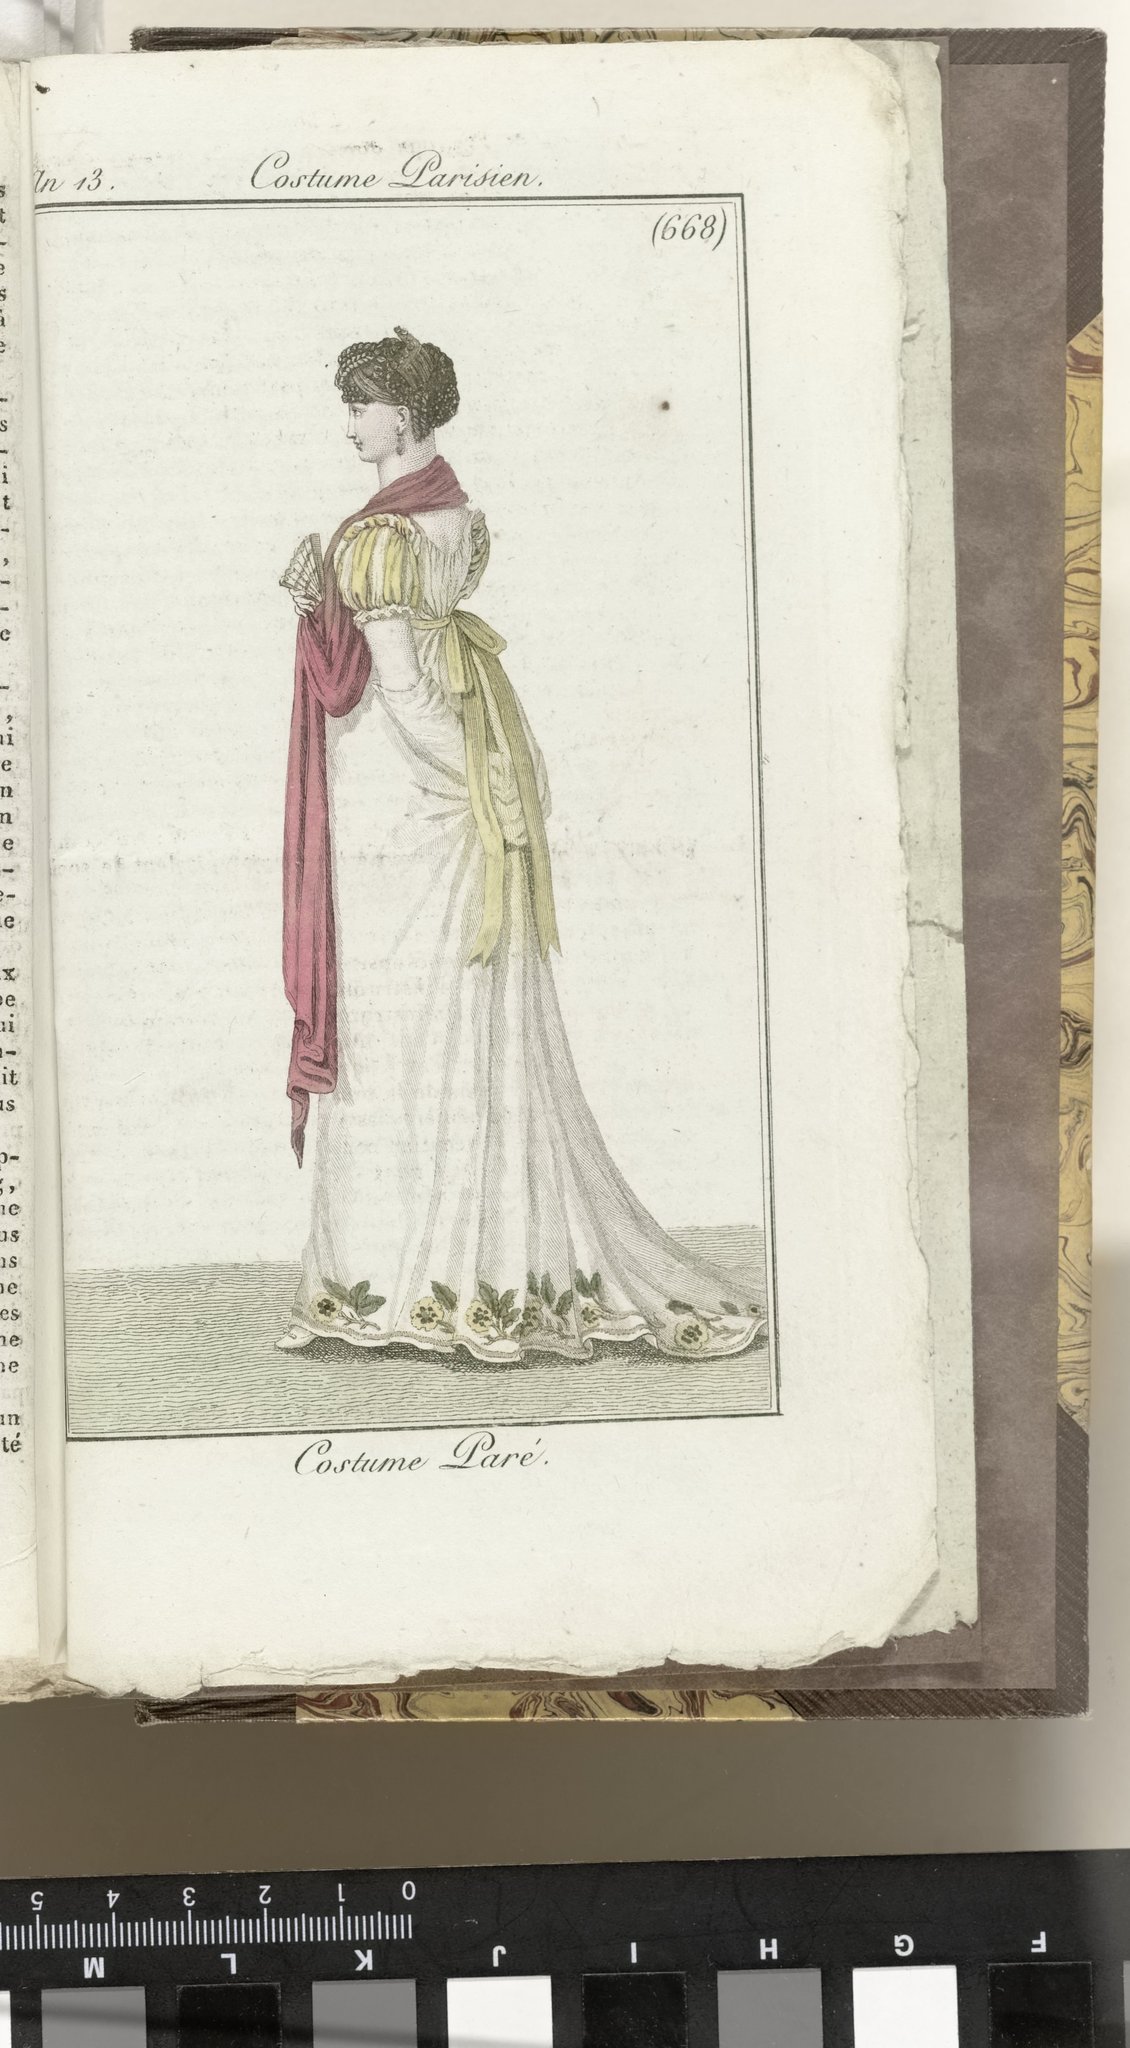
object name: fashion print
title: Journal des Dames et des Modes, Costume Parisien, 1805, An 13 (668) Costume Paré.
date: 1805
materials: paper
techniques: engraving, hand coloring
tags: bow (ornamental part of clothing) (+ women's clothes), gloves, mittens (long gloves) (+ women's clothes), border, ribbon, braid (+ women's clothes), neck-gear ~ clothing (shawl) (+ women's clothes), fashion plates, dress, gown (+ women's clothes), fan (+ women's clothes)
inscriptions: title: ‘Costume Paré.’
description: Vrouw naar links, in een "Costume Paré": witte japon met geel gestreepte pofmouwtjes en een geel lint als ceintuur om de hoge taille gestrikt. De onderrand van de rok is geborduurd met bloemen. Om de hals een roze lange sjaal. Kpsel..... Kleine waaier in de rechterhand. De prent maakt deel uit van het modetijdschrift Journal des Dames et des Modes, uitgegeven door Pierre de la Mésangère, Parijs, 1797-1839.